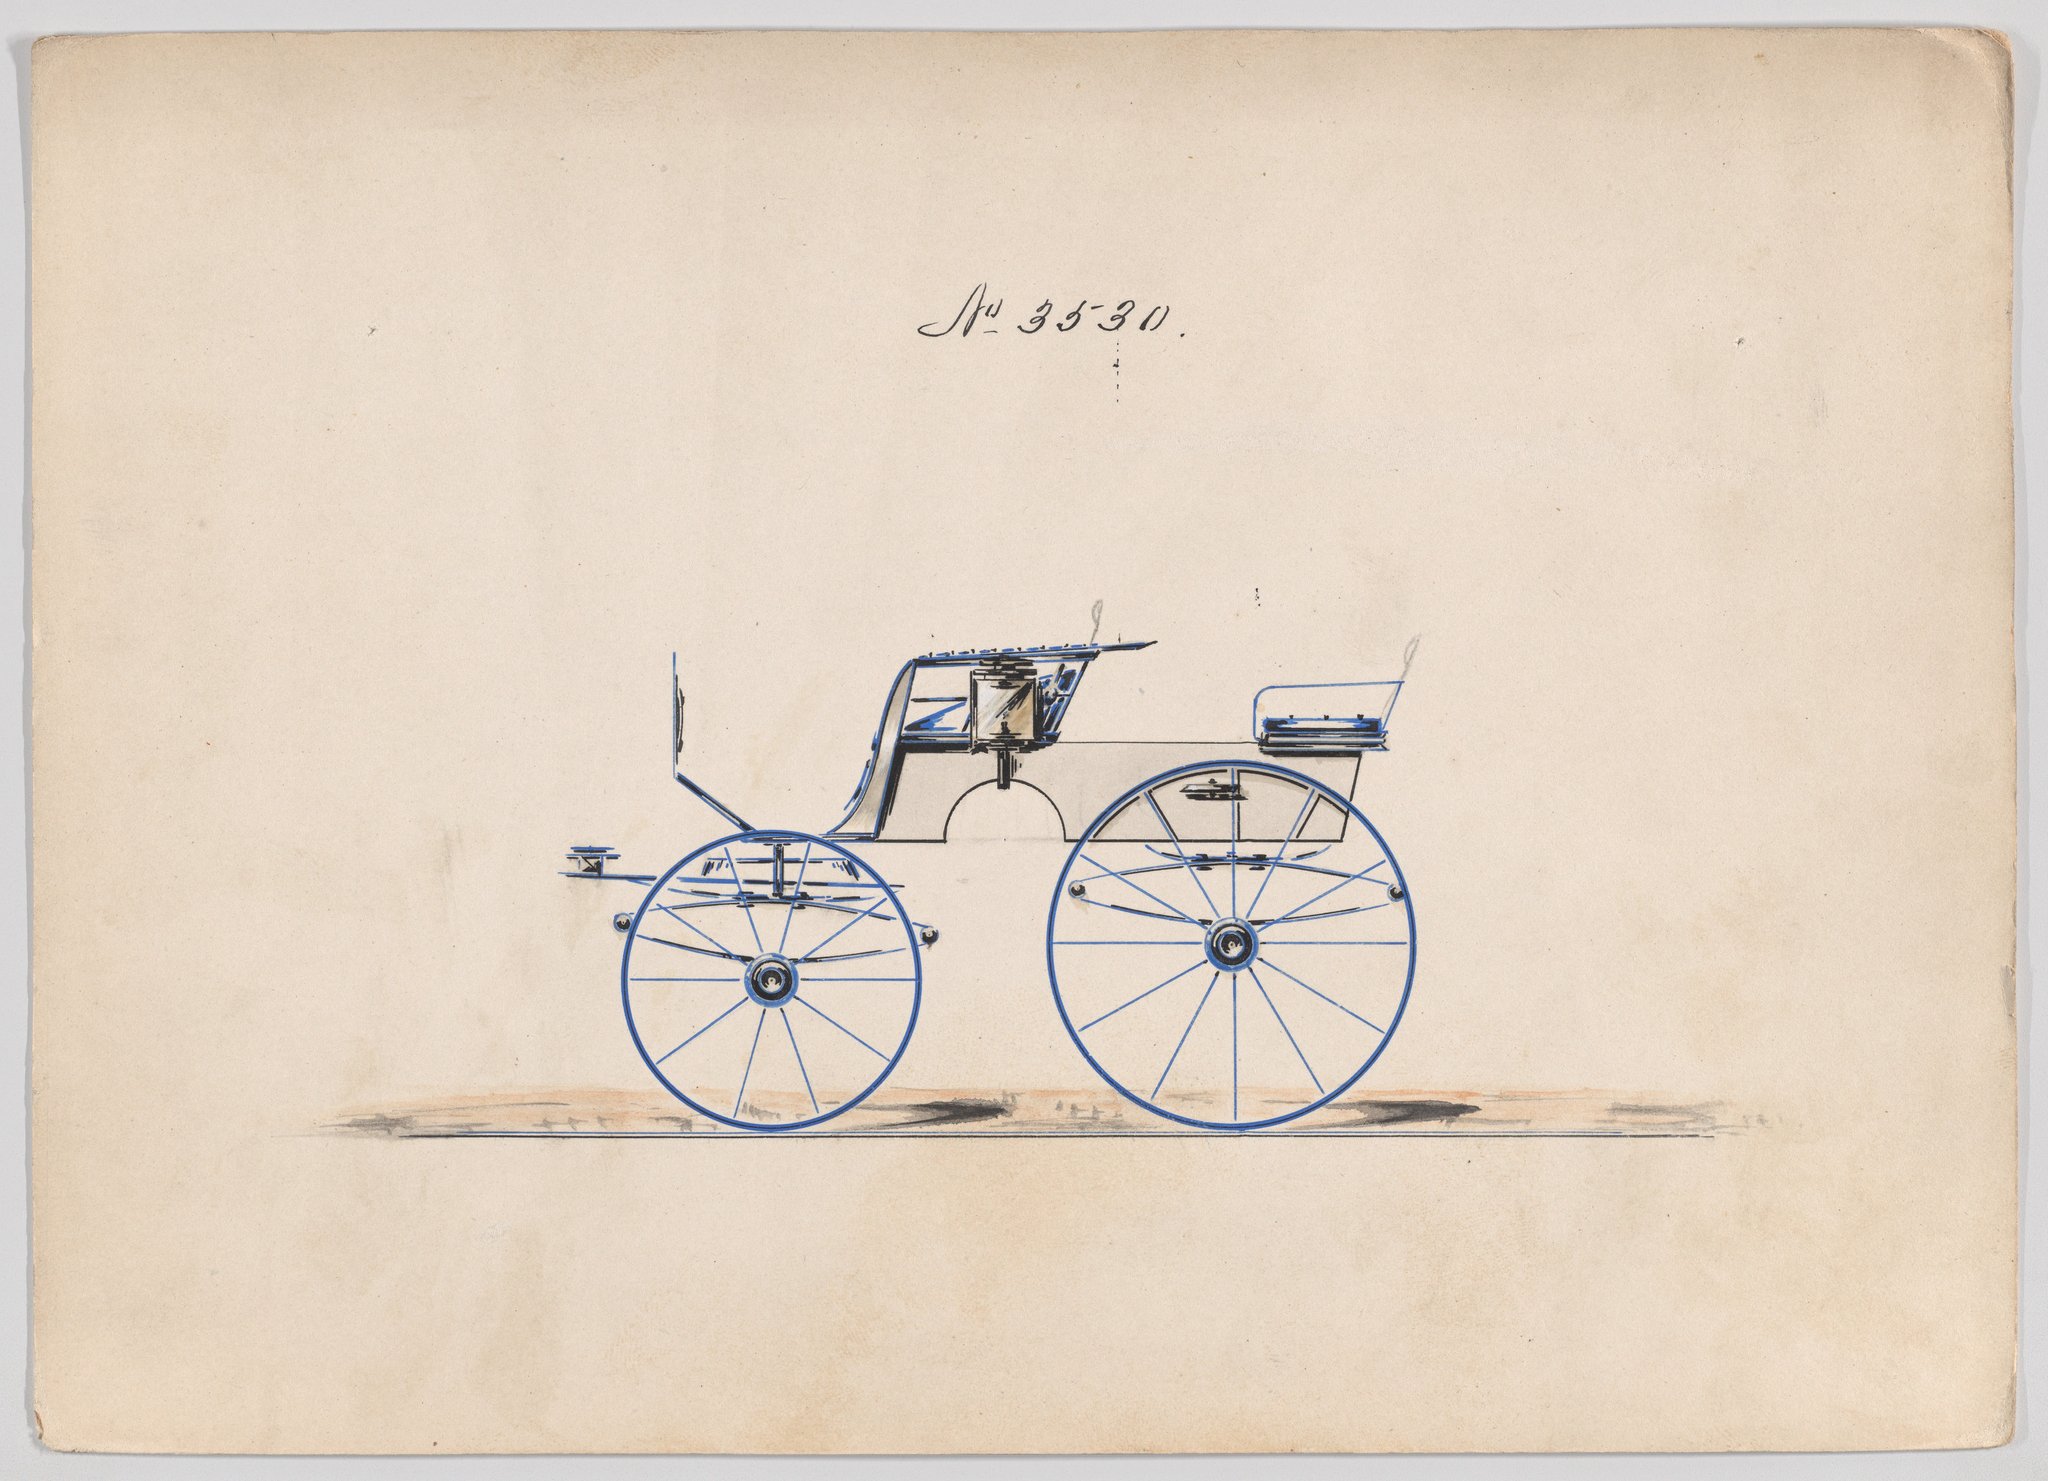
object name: drawing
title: Design for T-Cart, no. 3530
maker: brewster & co.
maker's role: manufacturer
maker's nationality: american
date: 1879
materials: gouache, gum arabic, ink, watercolor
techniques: pen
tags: carriages